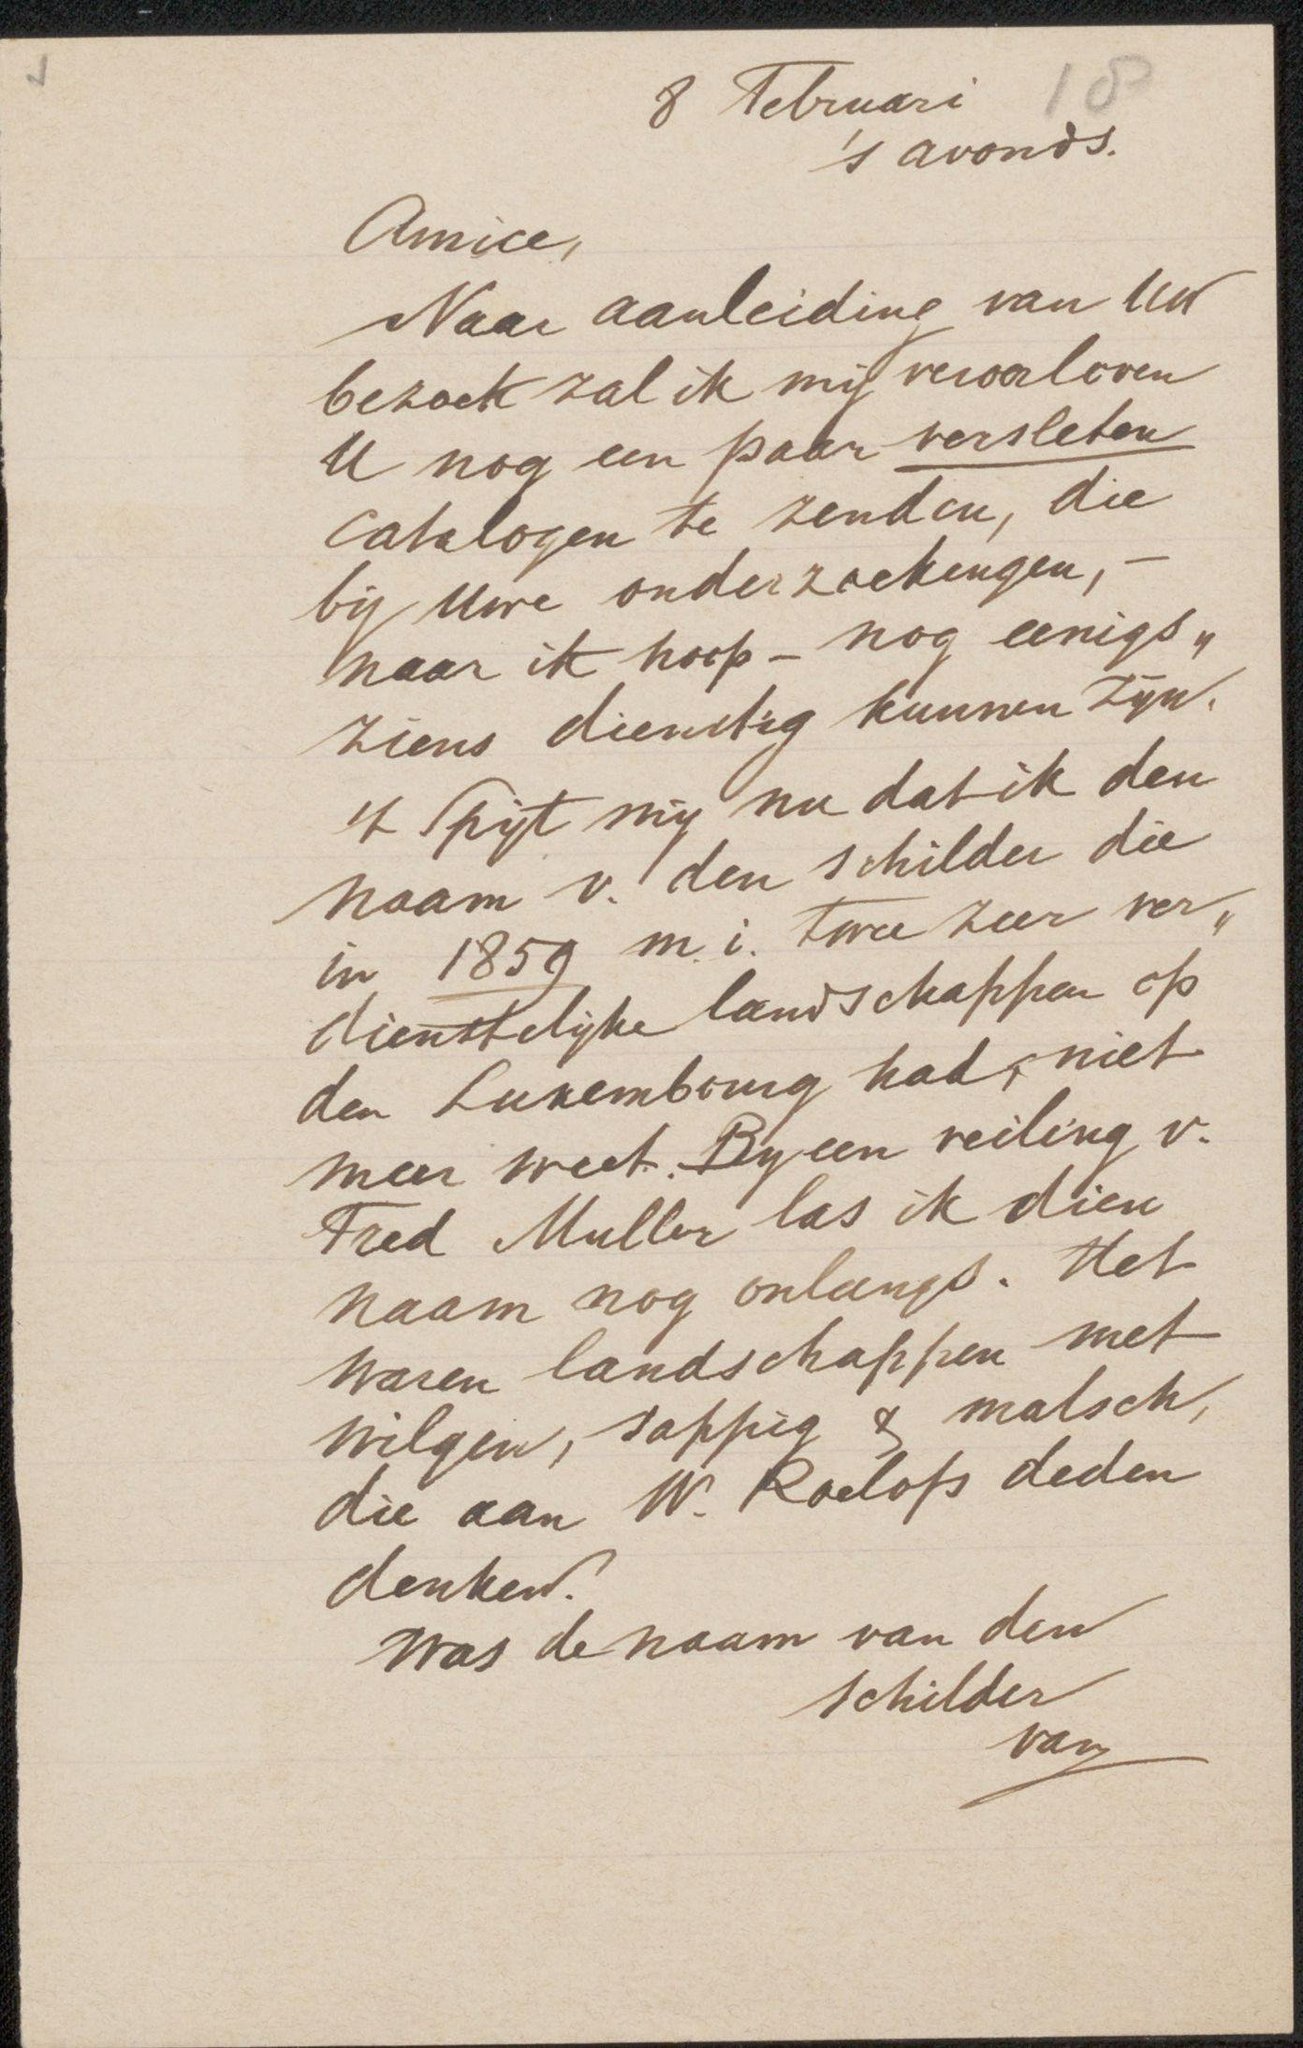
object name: letter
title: Brief aan Jan Veth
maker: august allebé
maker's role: draughtsman, print maker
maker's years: 1838-1927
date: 1859-1927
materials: ink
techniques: pen, writing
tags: painter, print maker, draughtsman, willem roelofs (i), dordrecht, designer, jan veth, wally moes, auguste couder, painting (including book-illumination, miniature-painting), printed matter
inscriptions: collector's mark: ‘RPK’